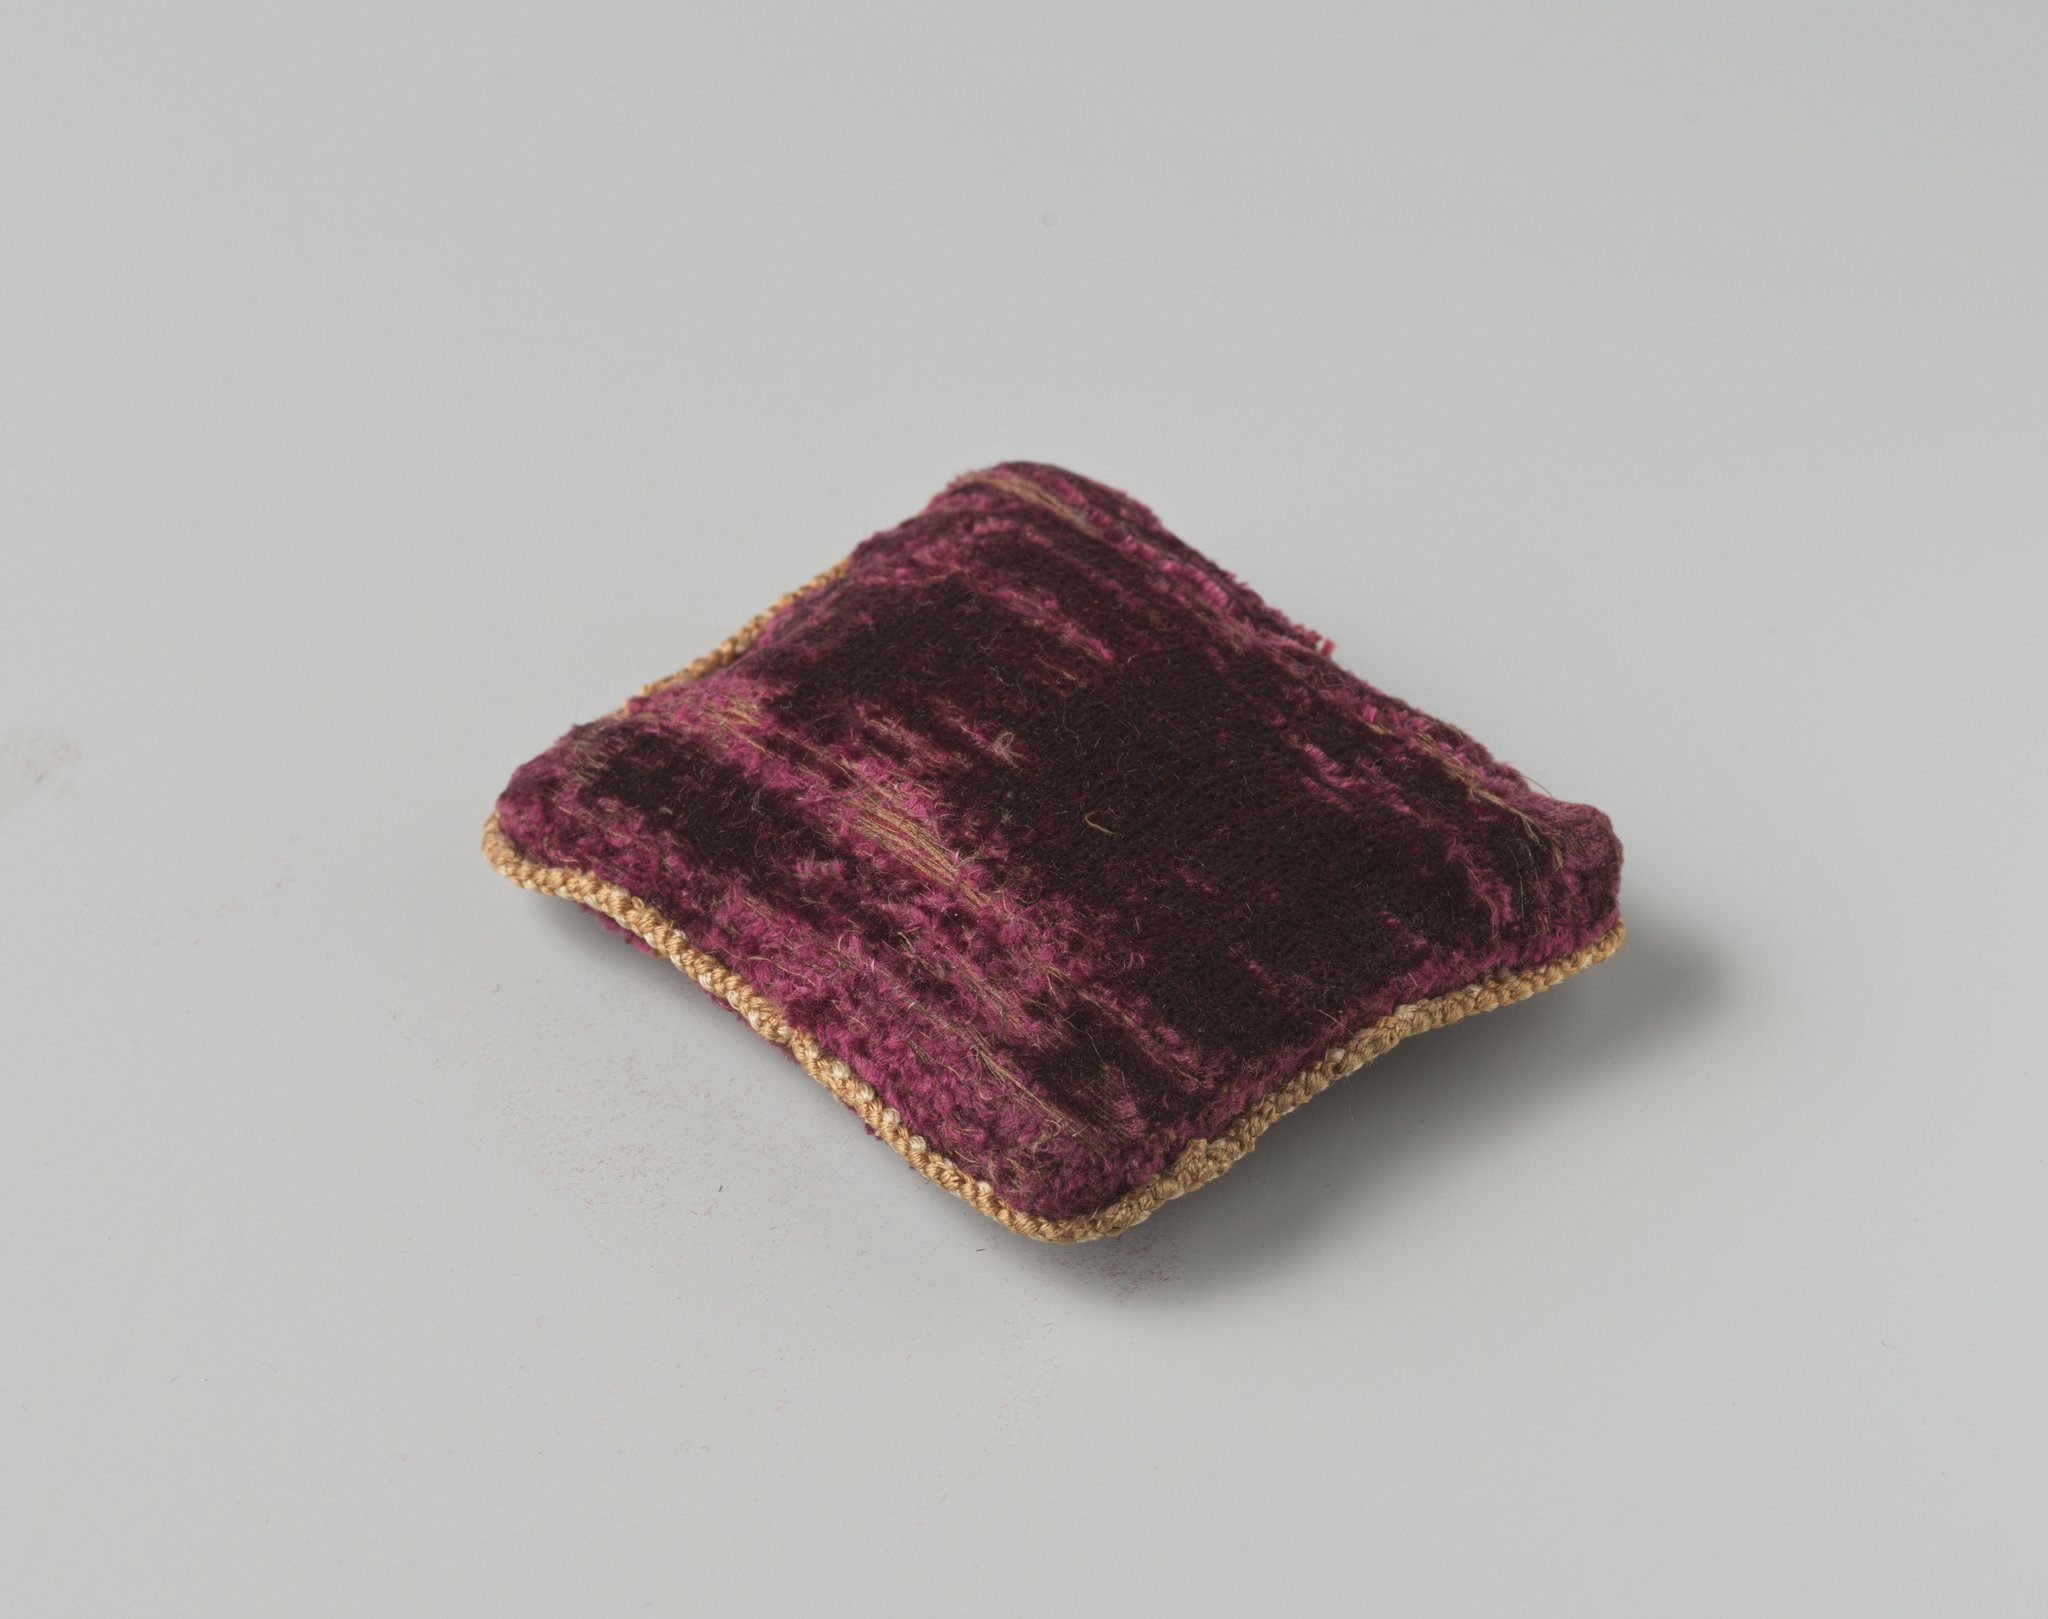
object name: miniature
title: Stoelkussen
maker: Anonymous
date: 1690-1710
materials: down, silk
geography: amsterdam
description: Rechthoekige dikke stoelkussen van bordeaux rode zijden fluweel, rondom afgezet met wit / bruin gevlochten koord van zijde. De vulling van dons was oorspronklijk zonder binnenhoes in het kussen gestopt.